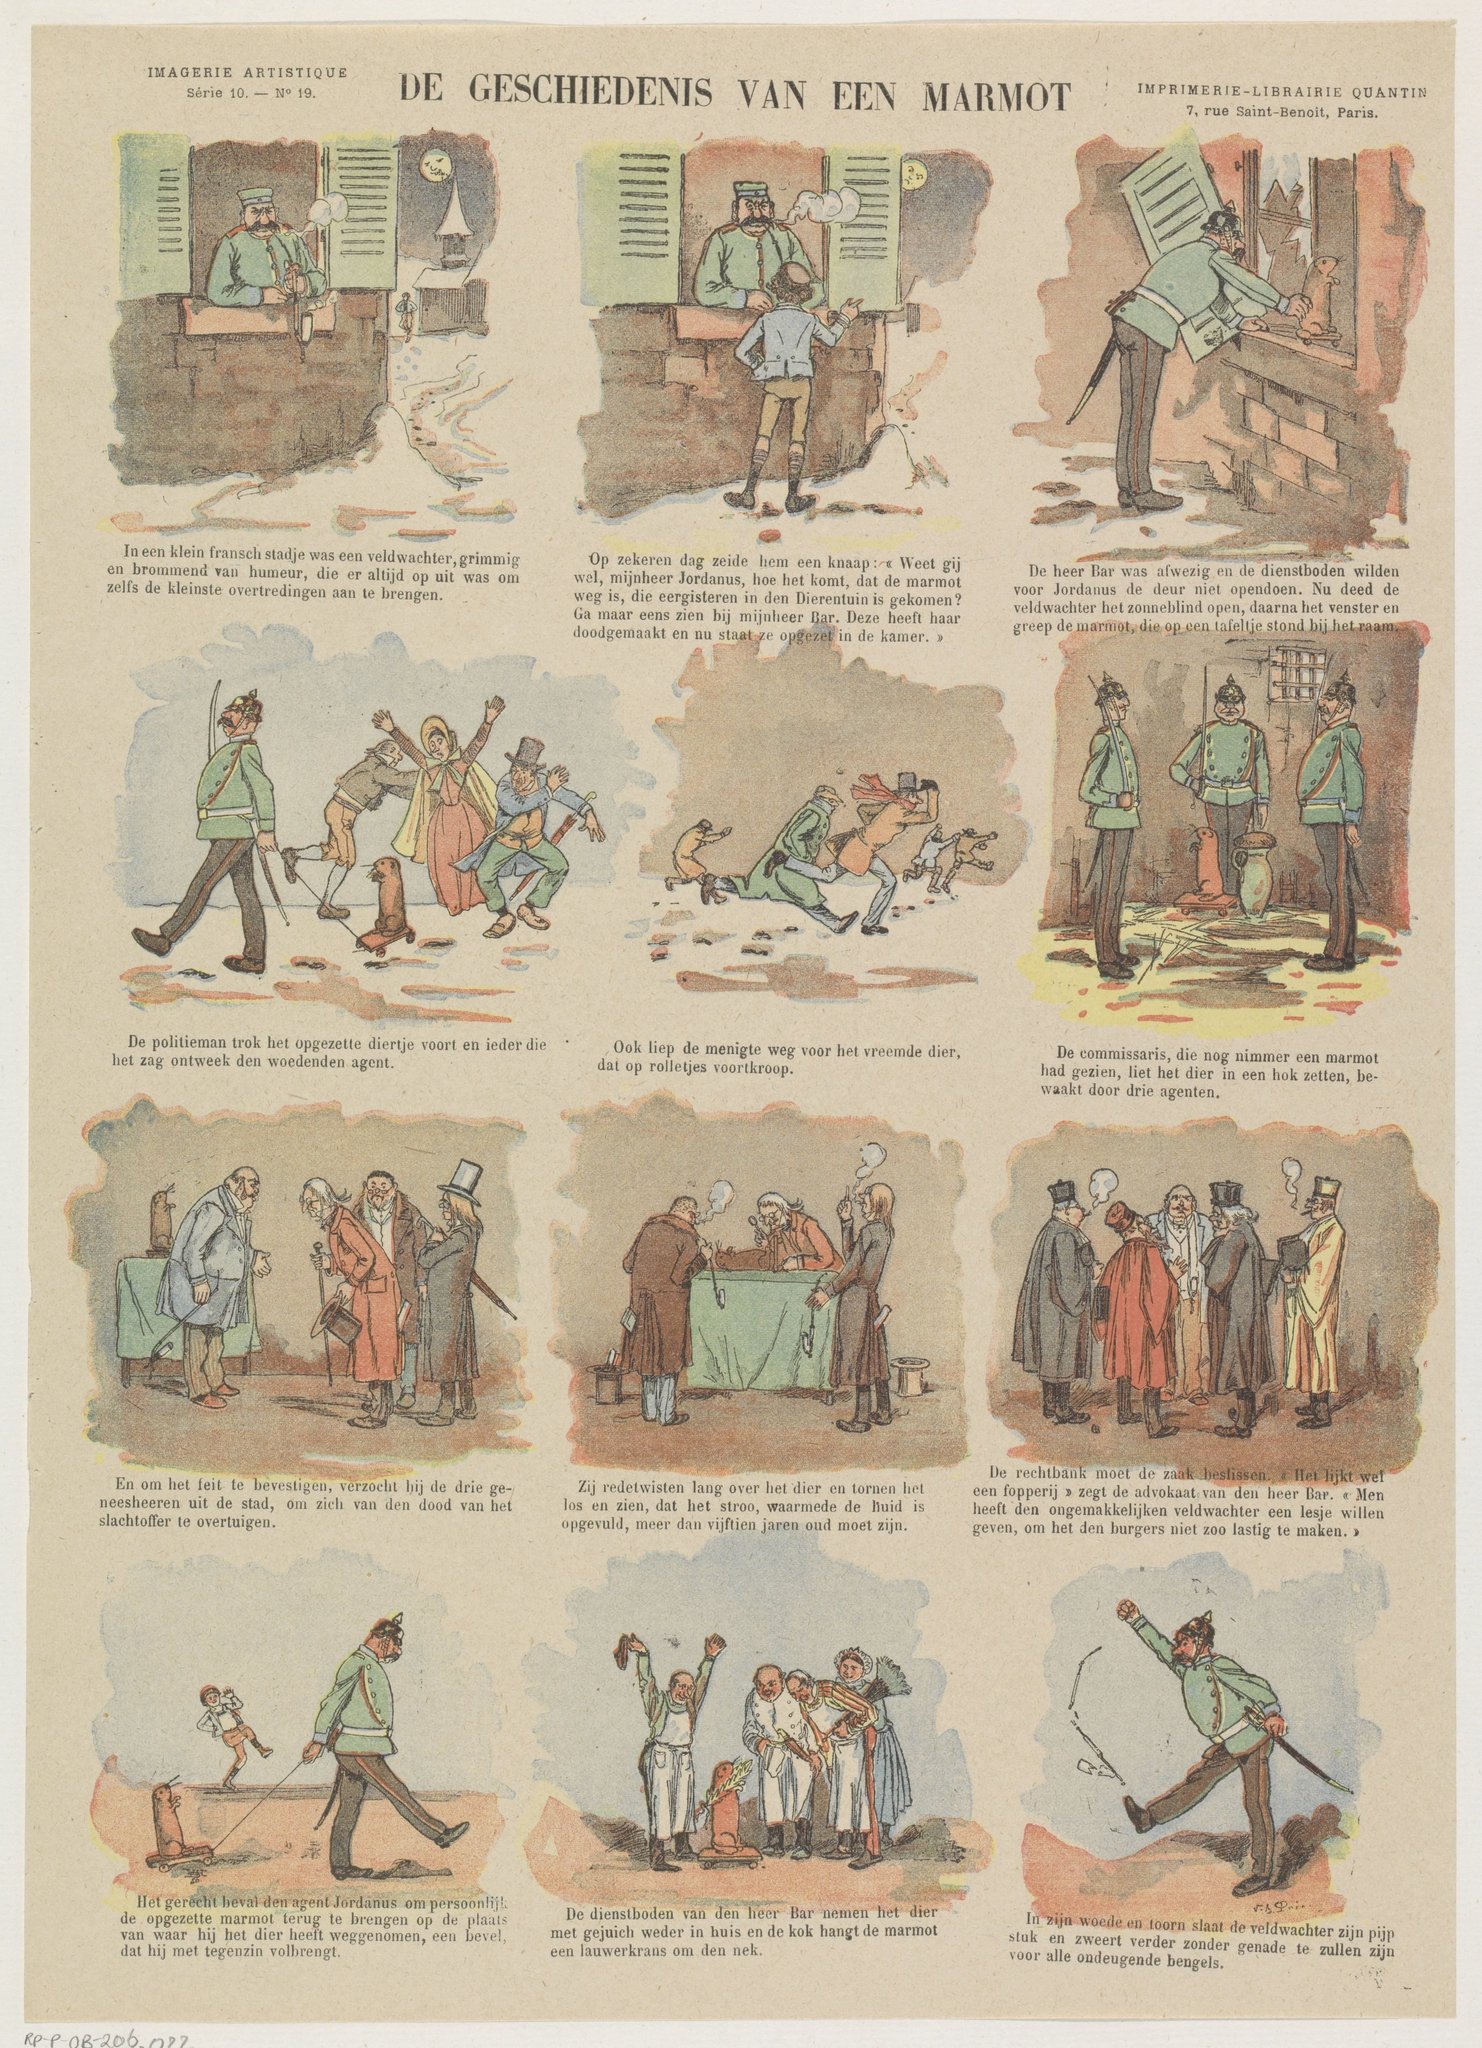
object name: popular print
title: Imagerie Artistique / Série 10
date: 1876-1890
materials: paper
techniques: lithograph, letterpress printing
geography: paris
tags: animals (+ stuffed animal), theft, tales and fairy tales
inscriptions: collector's mark: Lugt 2760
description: Blad met 12 voorstellingen uit het verhaal van de boze veldwachter en de opgezette marmot. Onder elke afbeelding een onderschrift. Genummerd linksboven: Série 10. - No. 19.